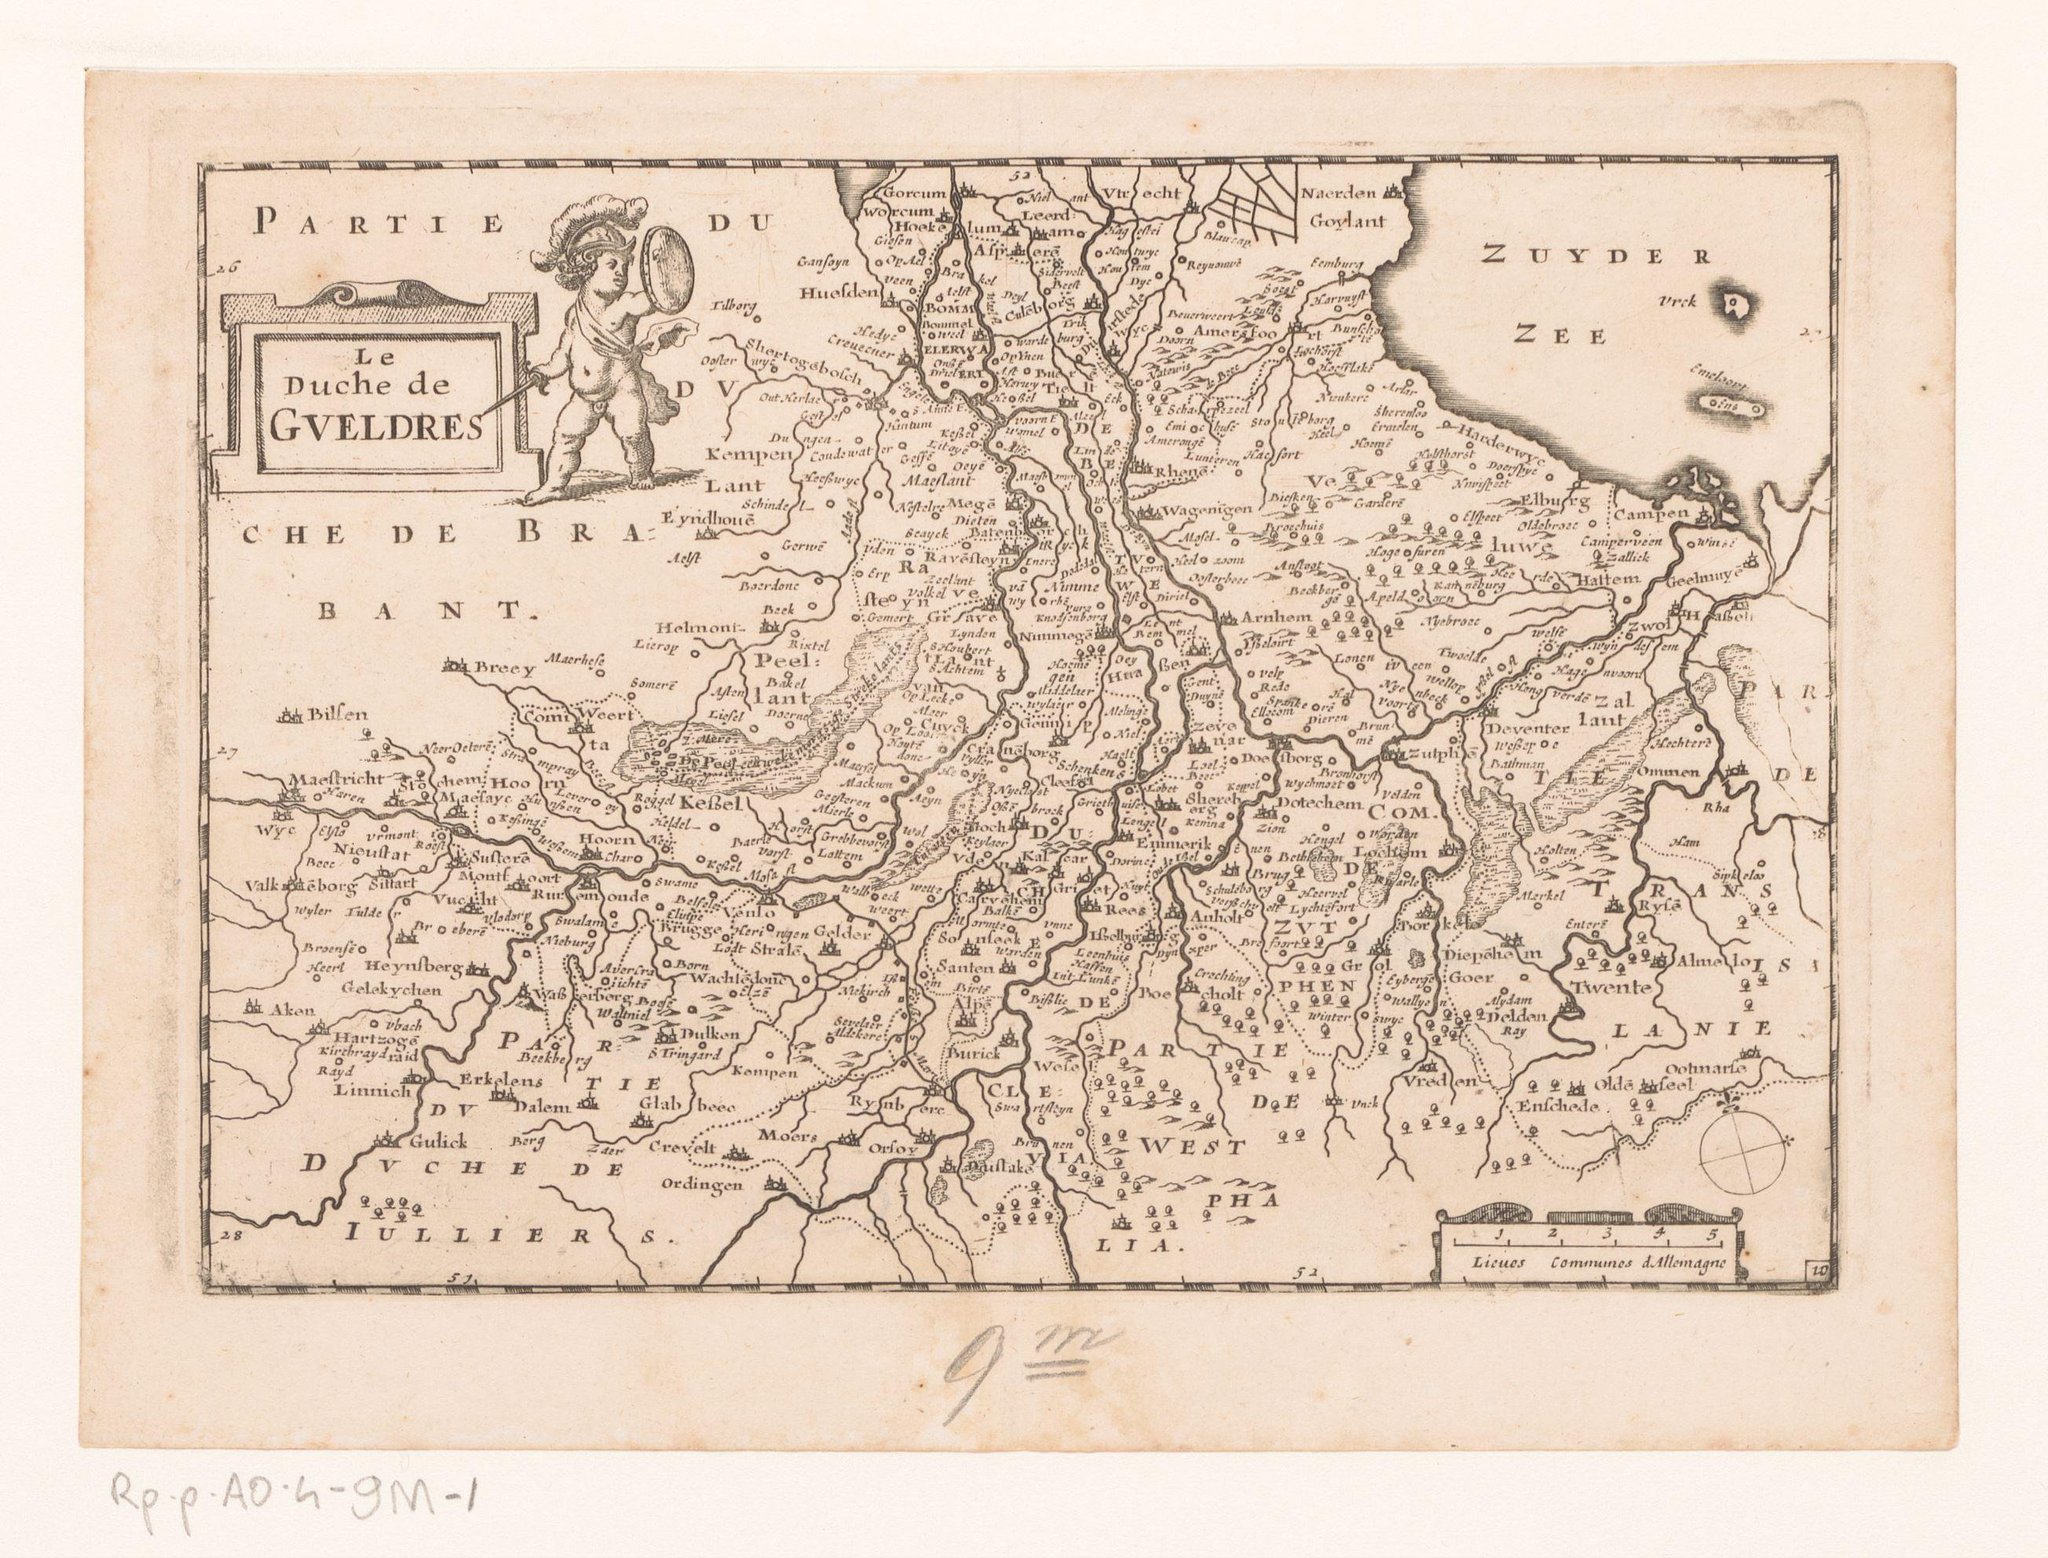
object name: print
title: Le duche de Gueldres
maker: Anonymous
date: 1635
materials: paper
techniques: engraving, etching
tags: maps of separate countries or regions, gelderland, guelders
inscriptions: collector's mark: Lugt 2228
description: Deze staat van prent ook gebruikt in: De vyerighe colom klaer vertoonende in vyftich onderscheydene curieuse caarten de XVII. Nederlantsche Provincien (…). Amsterdam: Jacob Aertsz Colom (I), s.a. [ca. 1660]. En in latere uitgaven met de platen van deze publicatie, uitgegeven door Pieter van Alphen (1691) en Pieter van der Slaart (1696). Eerdere staat van prent (zonder '10' rechtsonder) ook gebruikt in eerdere drukken van deze publicatie